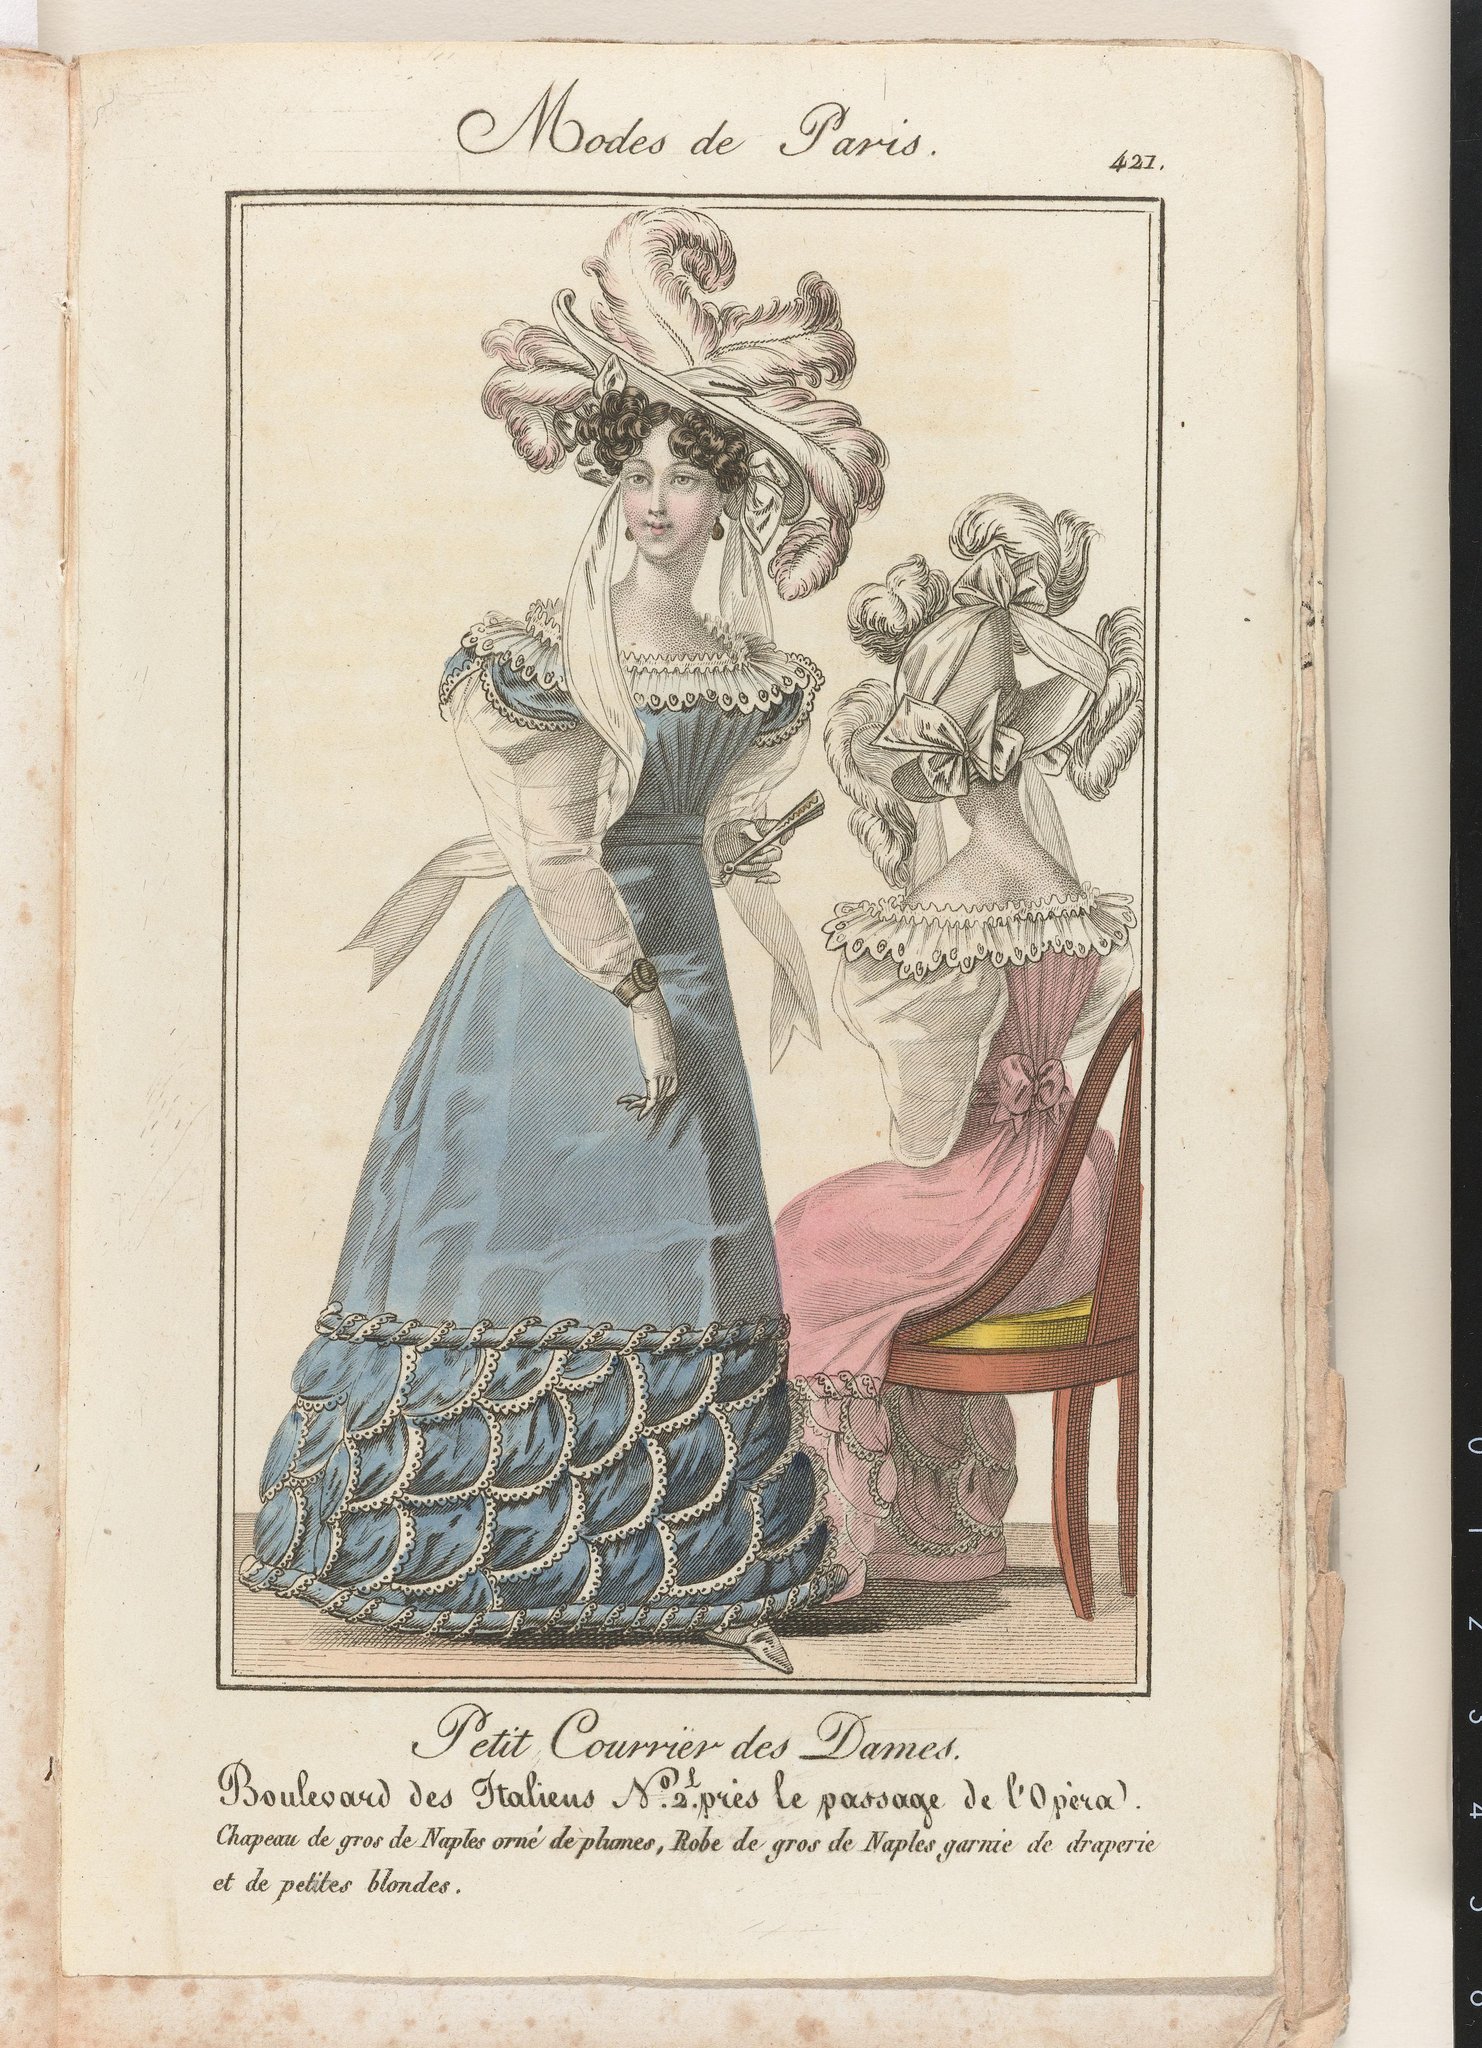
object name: fashion print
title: Petit Courrier des Dames, ou Nouveau Journal des Modes, des Théatres, de la Litterature et des Arts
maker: Anonymous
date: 1826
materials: paper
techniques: engraving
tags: fashion plates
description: Prent uit het modetijdschrift Petit Courrier des Dames (1821-1868).